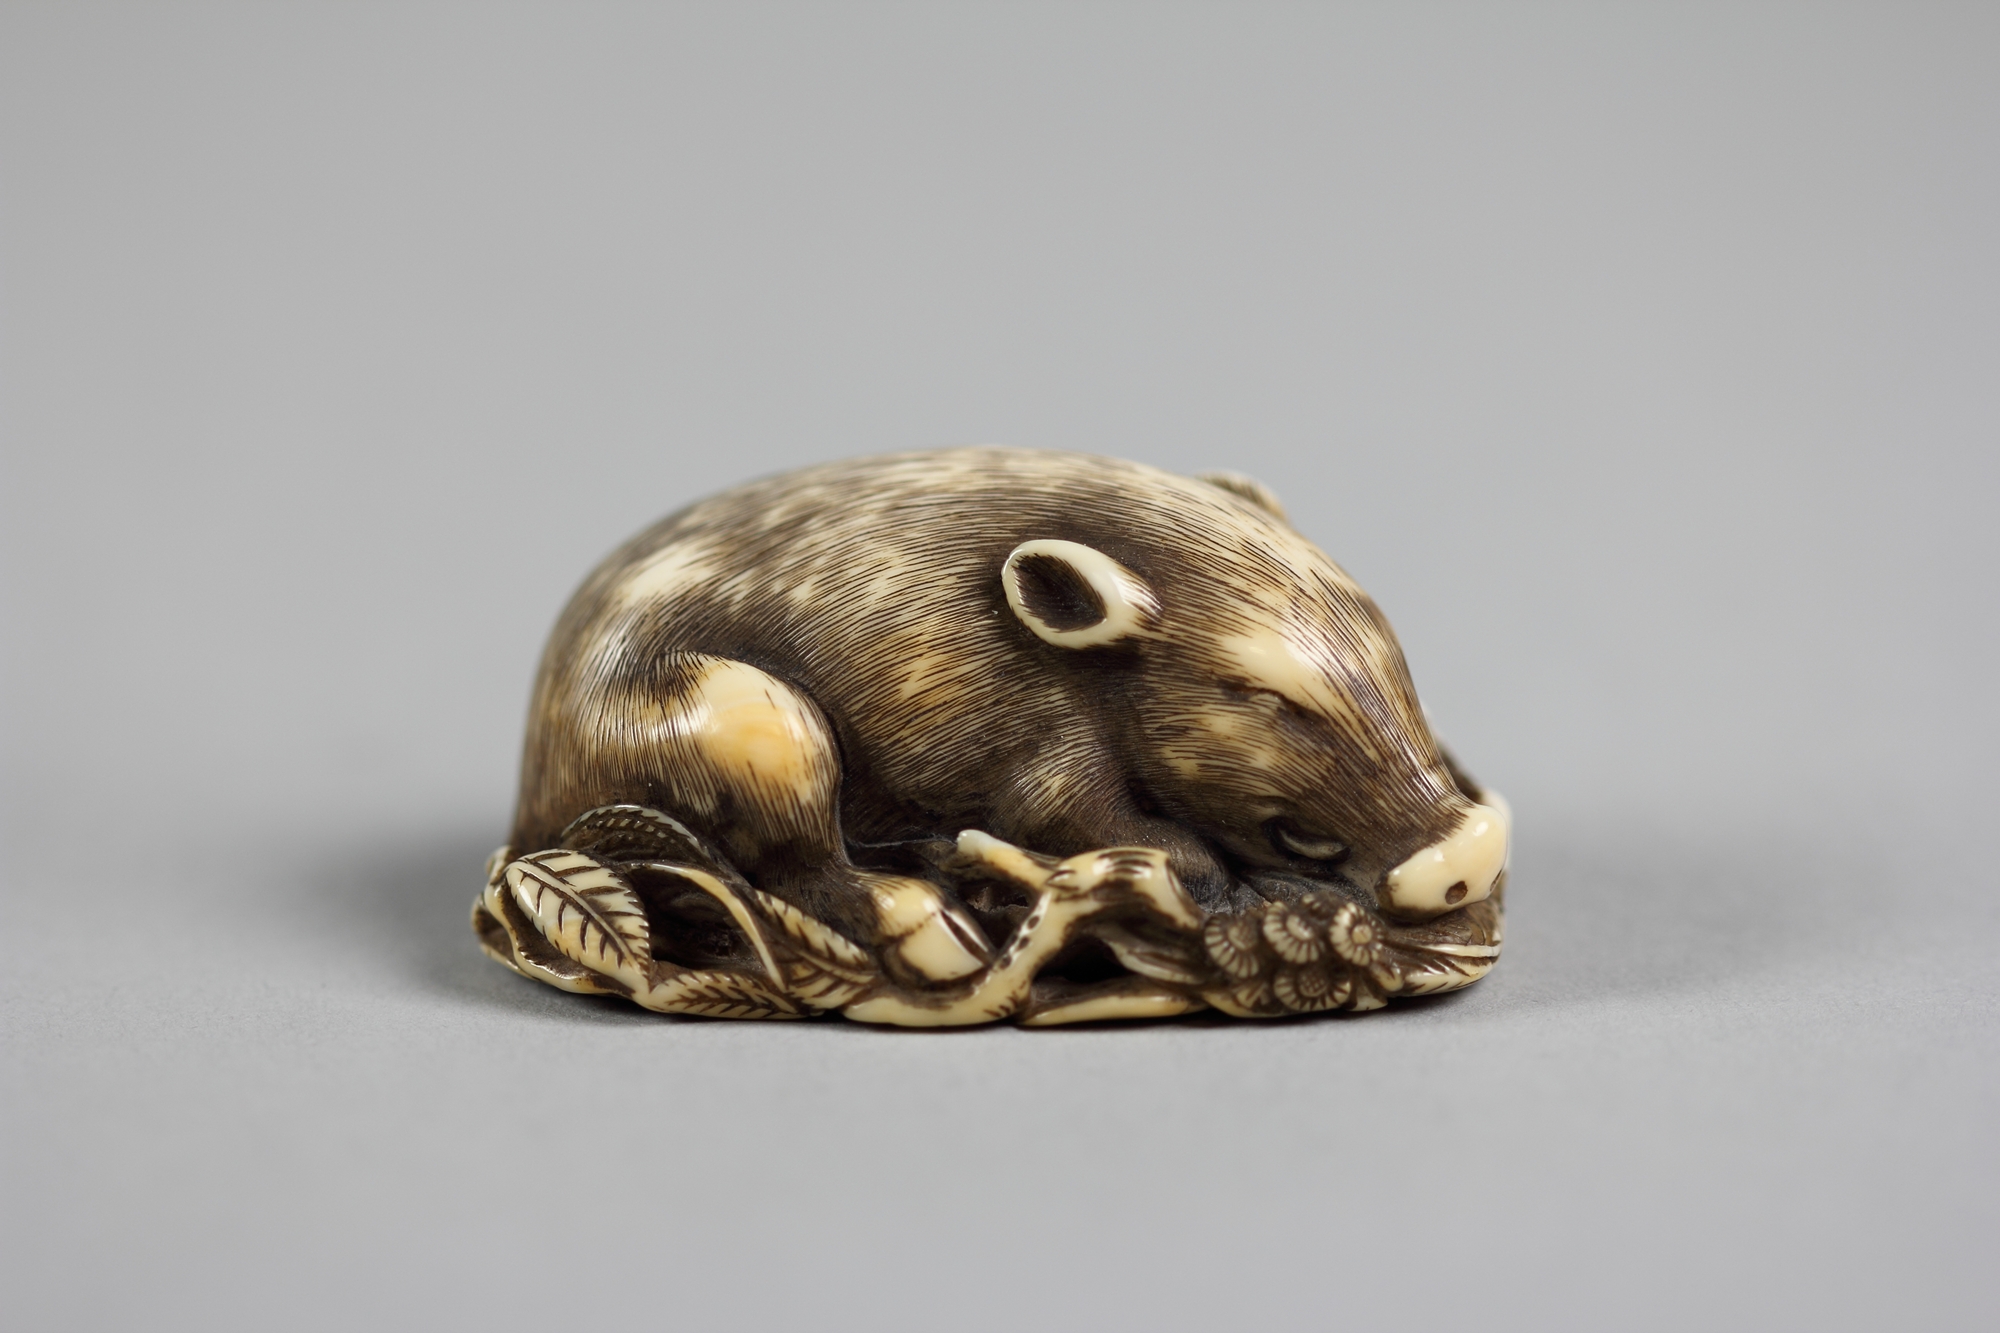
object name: netsuke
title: Boar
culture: japanese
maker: tomotada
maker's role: artist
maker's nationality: japanese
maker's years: 1777-1833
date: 1767-1833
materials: ivory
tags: boars